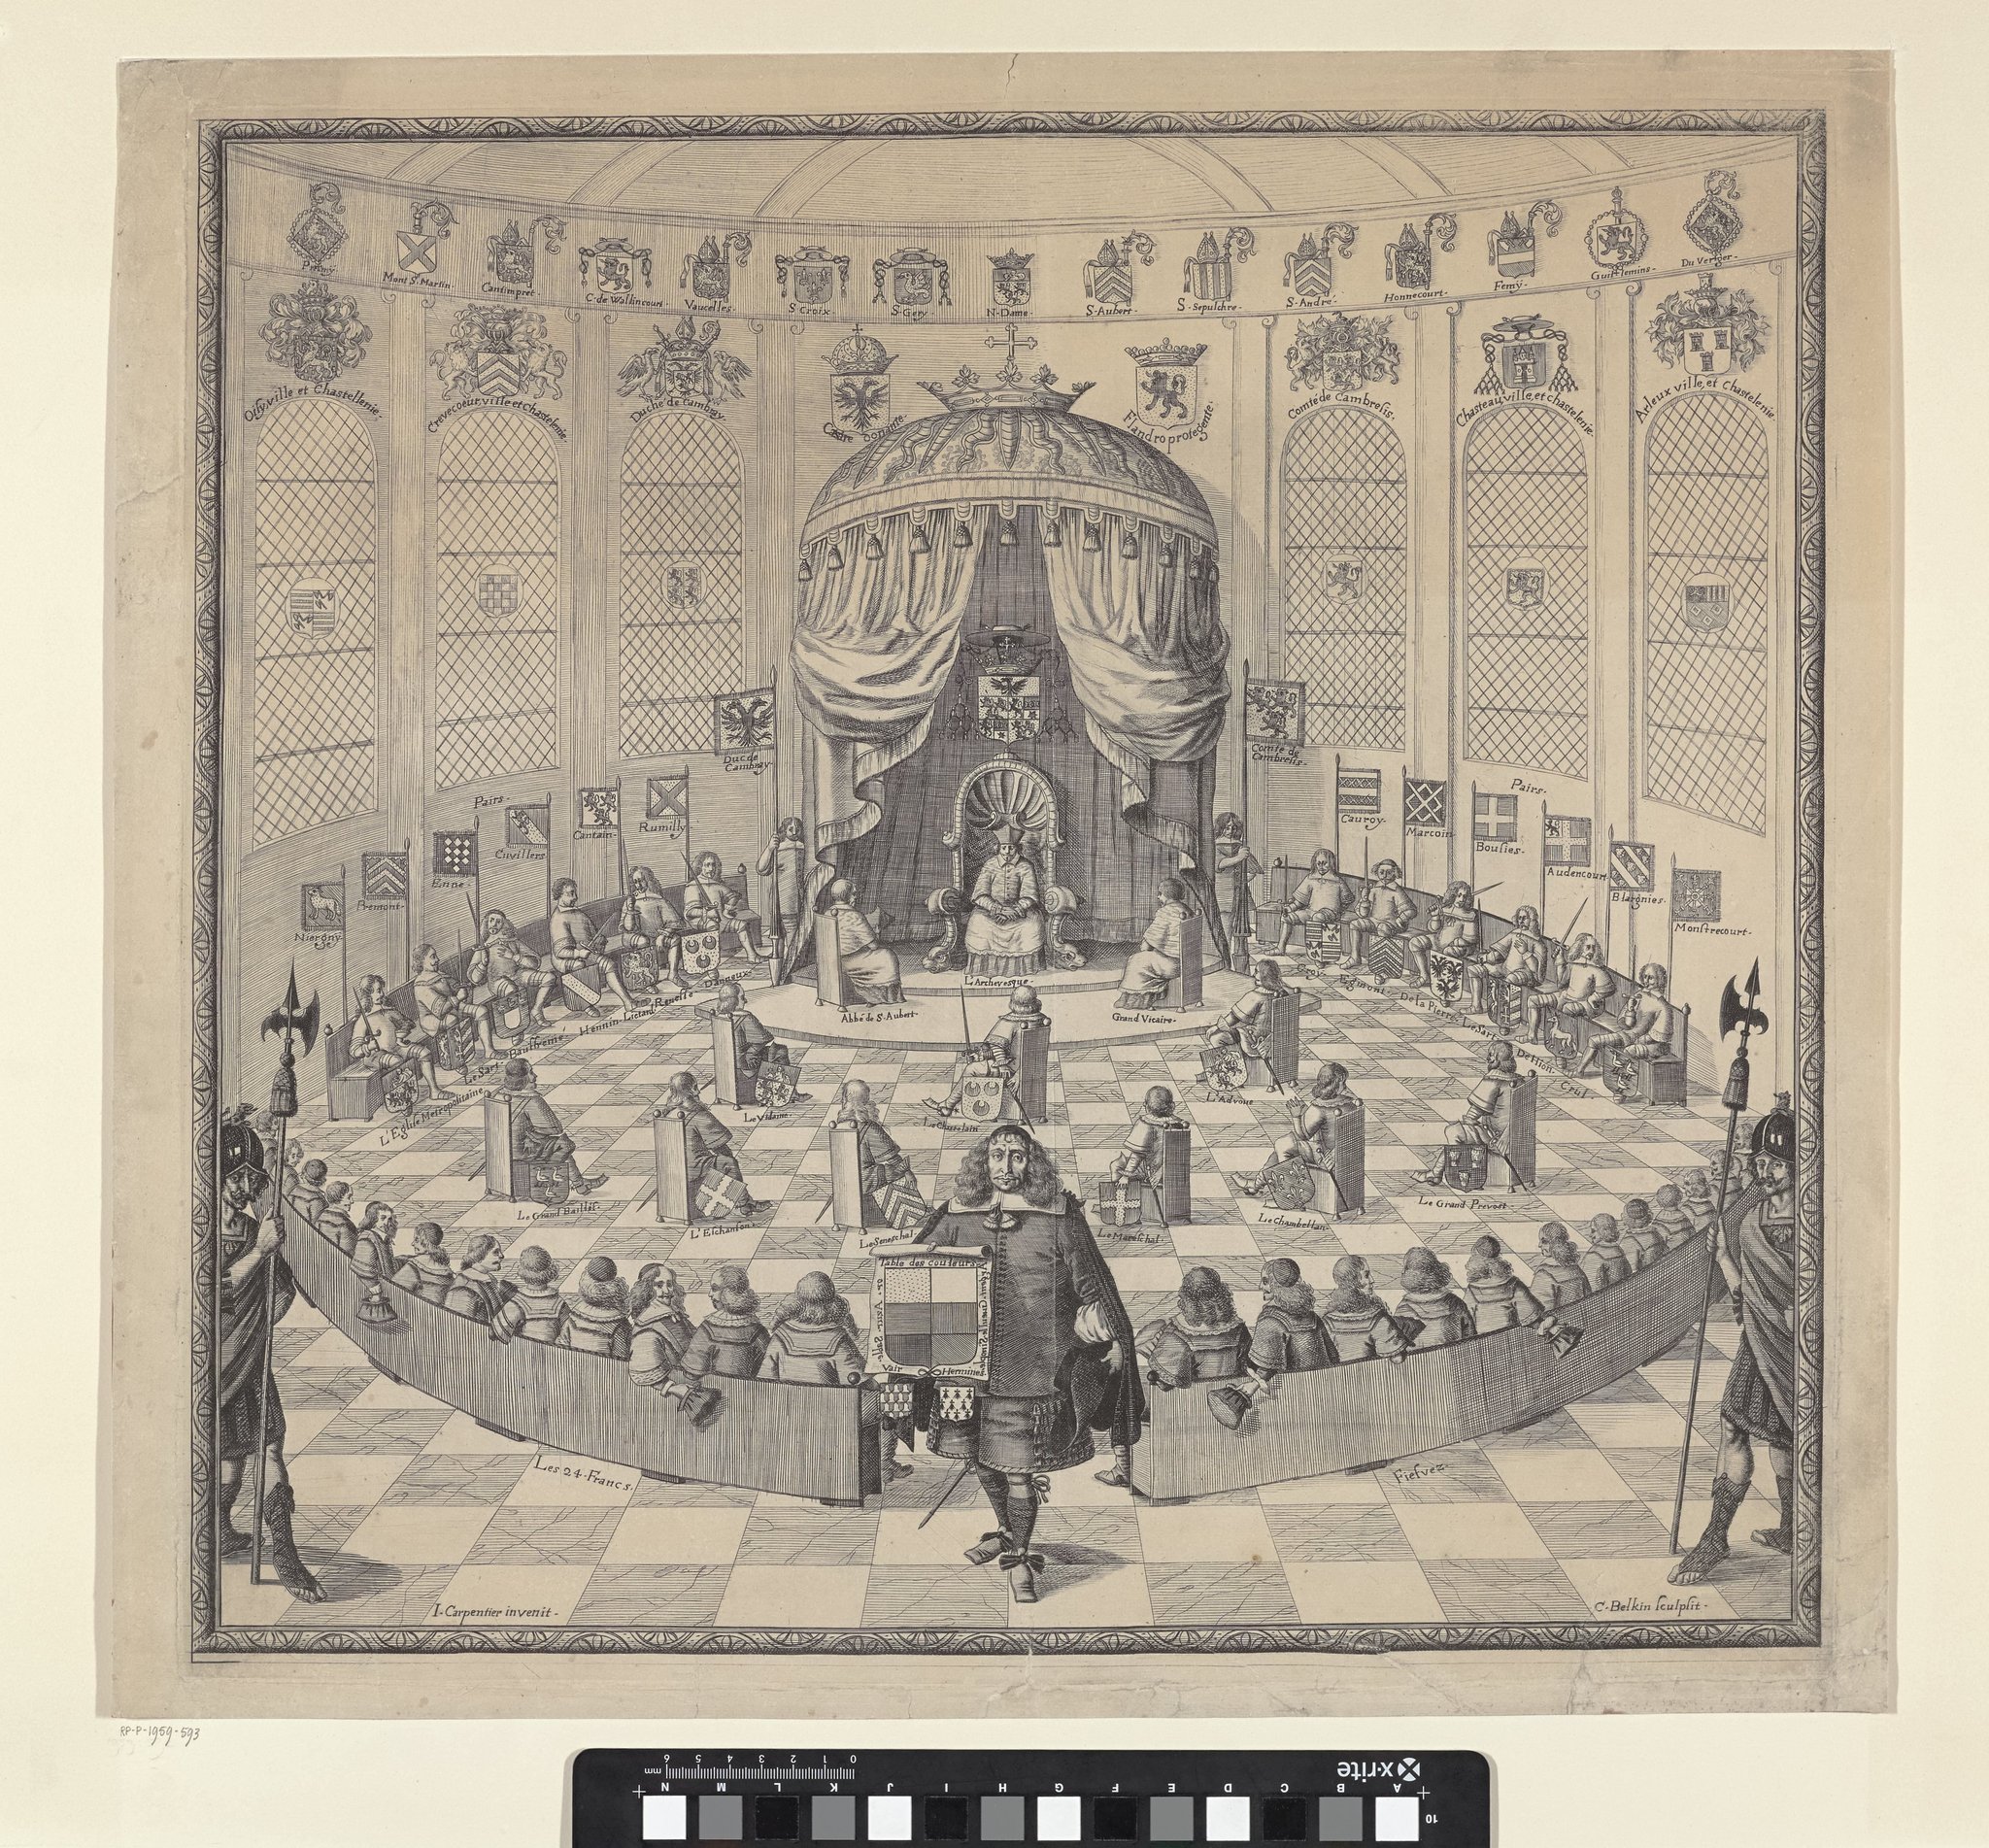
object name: print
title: Interieur van kapittelzaal van kathedraal van Cambrai met tronende aartsbisschop temidden van ridders en hoogwaardigheidsbekleders met hun wapenschilden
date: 1664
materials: paper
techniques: engraving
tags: archbishop, bishop, etc. (roman catholic)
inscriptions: collector's mark: Lugt 2760, collector's mark: Lugt 2228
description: 1e staat; verschillend van die in het boek. Hind II, p. 37. Prent gebruikt voor: Carpentier, Jean Le, Histoire genealogique des Païs-Bas, ou Histoire de Cambray, et du Cambresis, Leiden 1664. Deze eerste staat wijkt af van exemplaar in uitgave.